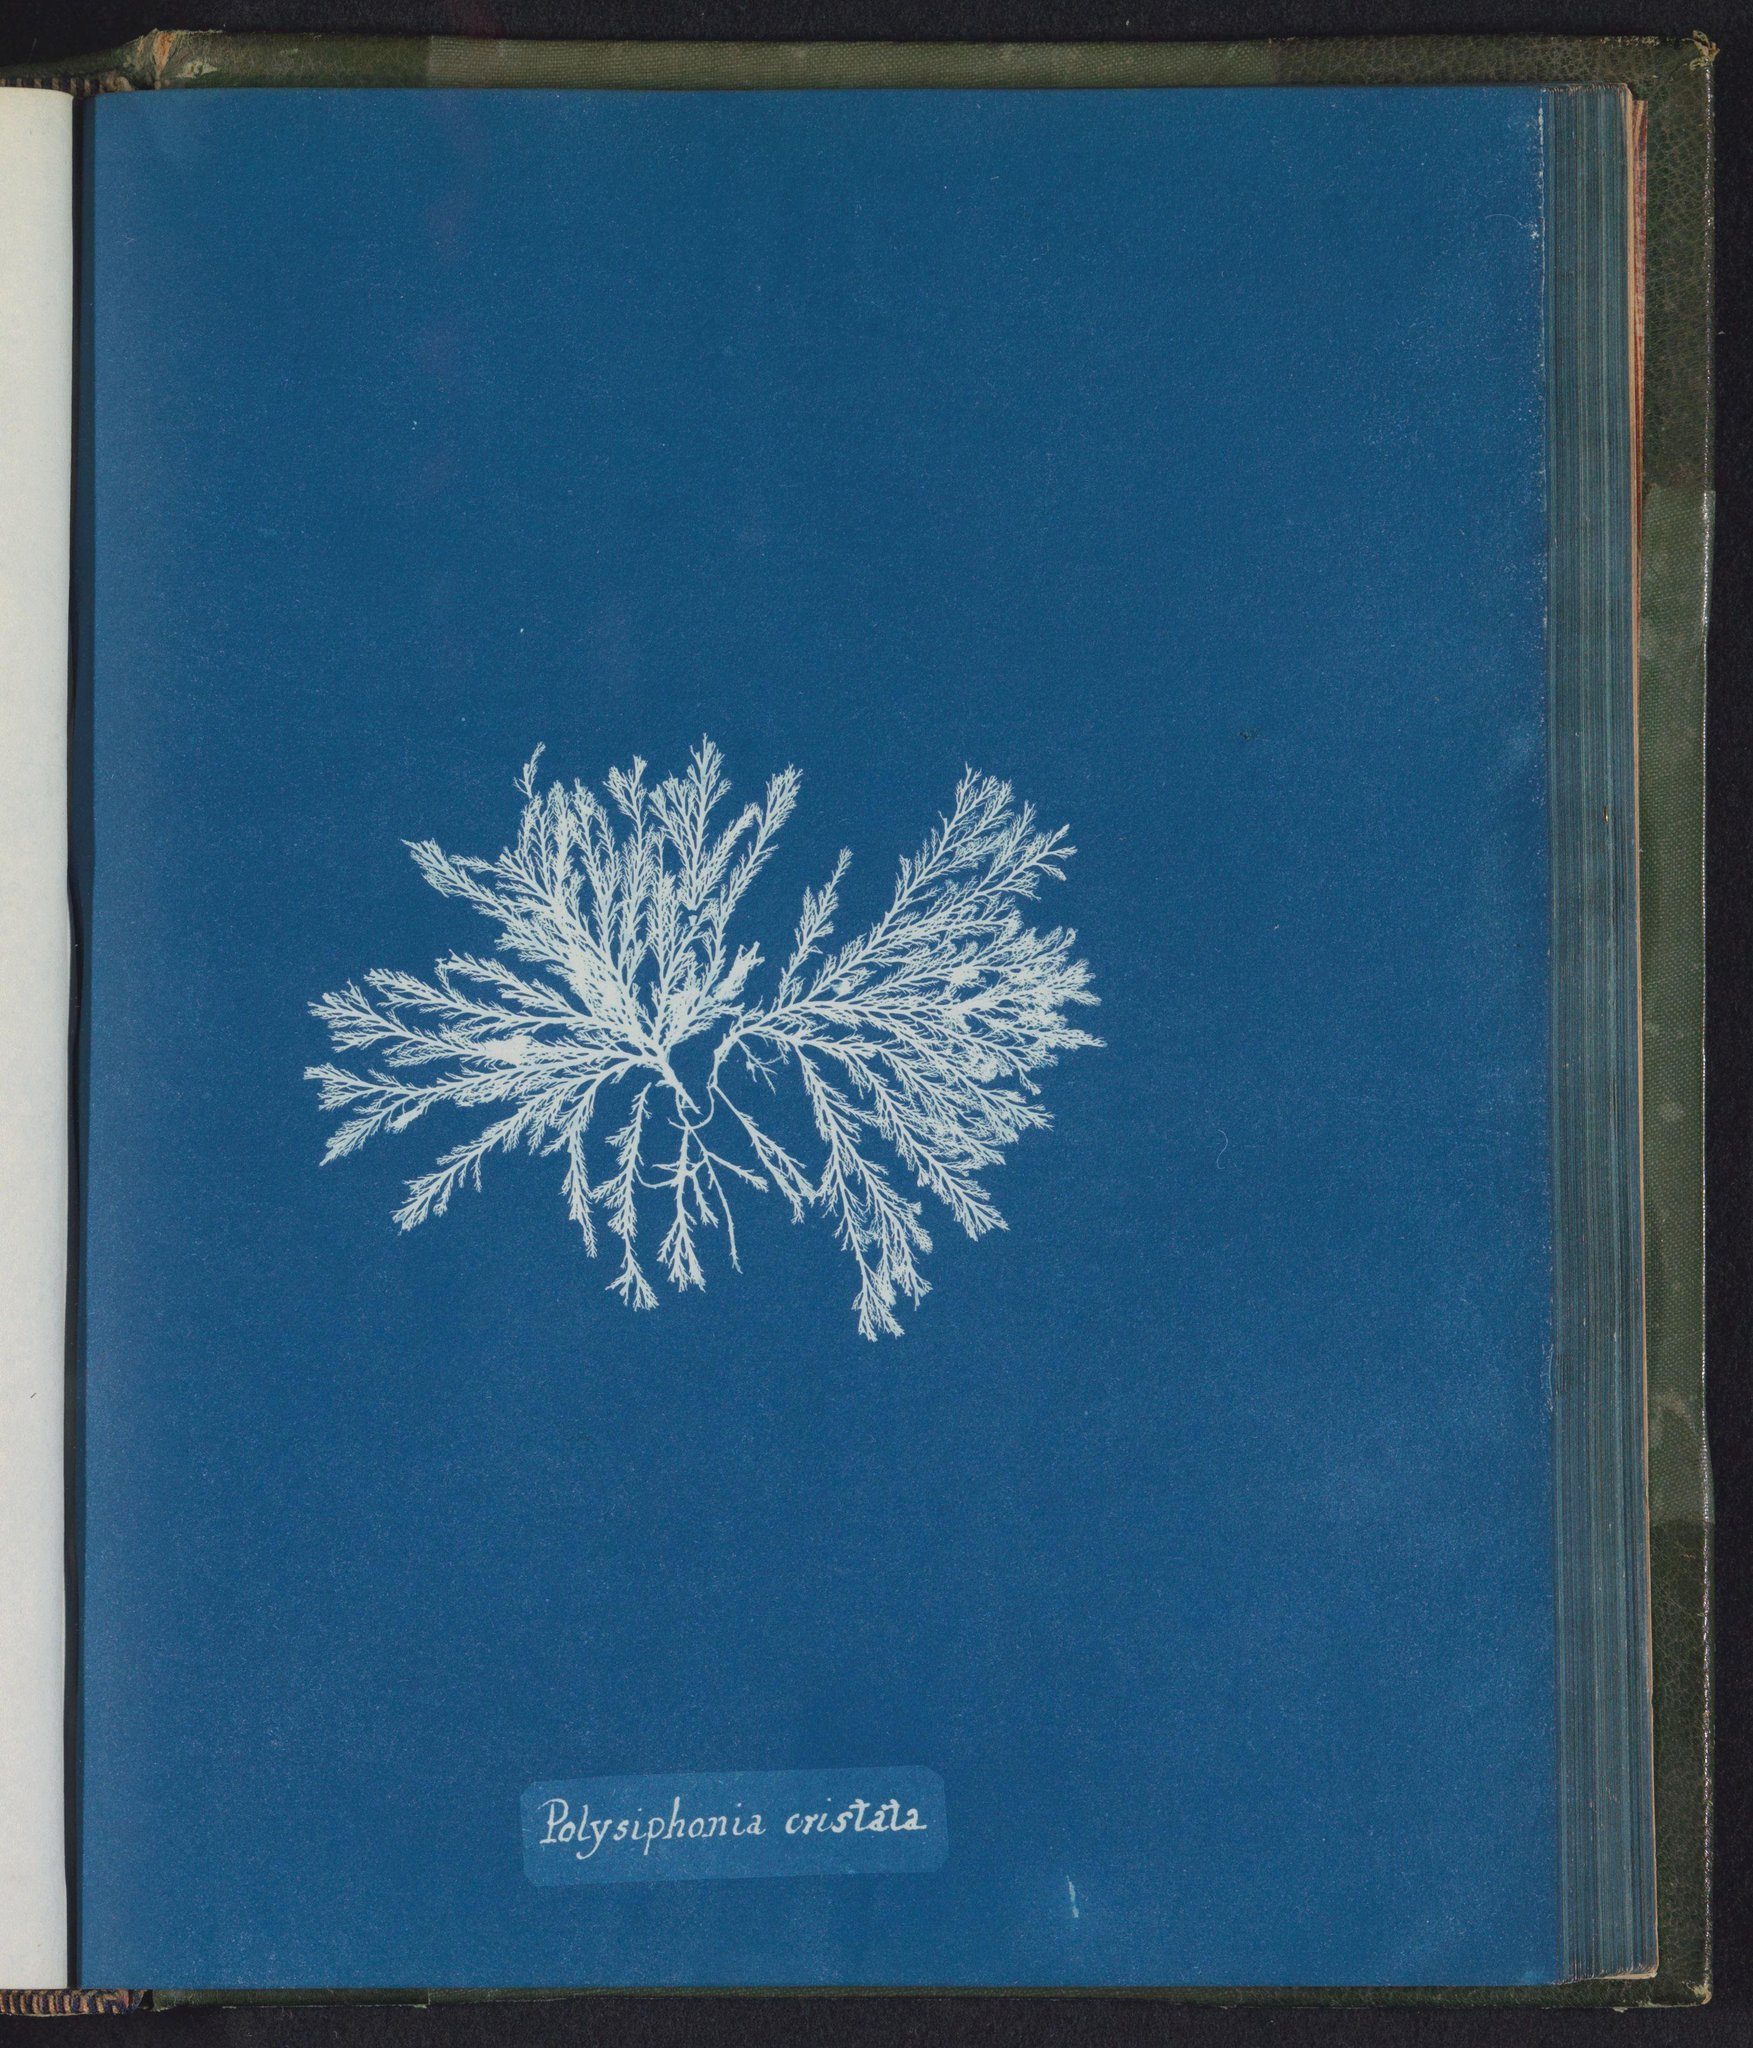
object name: page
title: Zeewier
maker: anna atkins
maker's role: fotograaf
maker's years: 1799-1871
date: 1843-1853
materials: photographic support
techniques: cyanotype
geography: united kingdom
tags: algae, seaweed